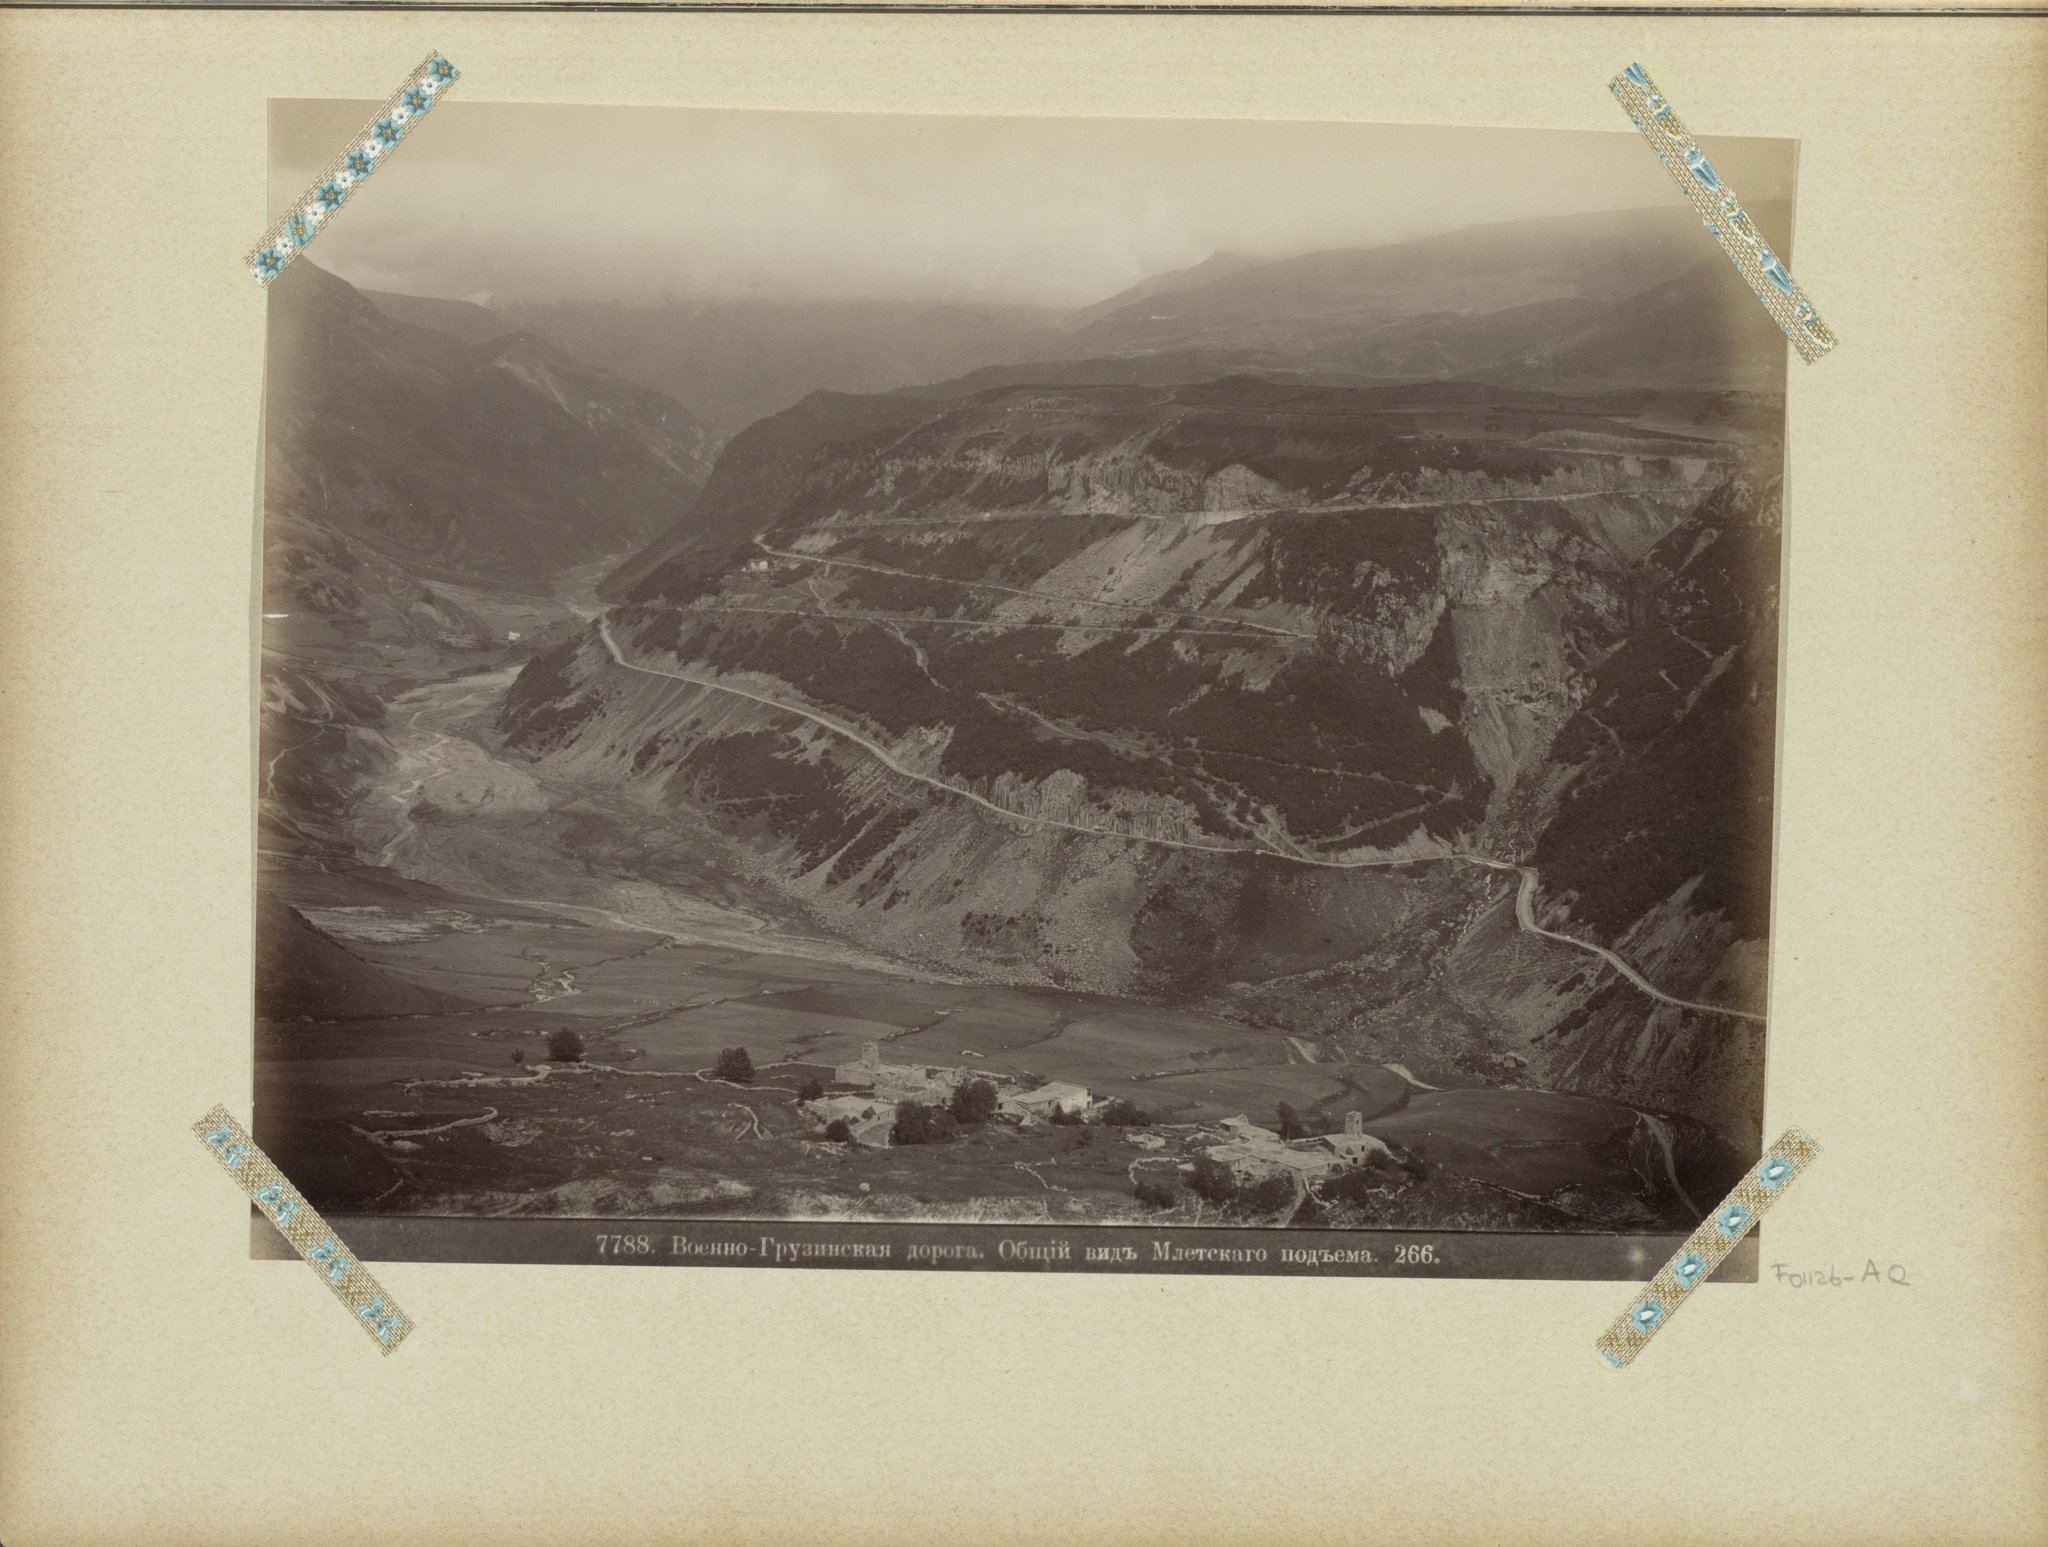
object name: photograph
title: Berglandschap met dorp aan de militaire weg in Georgië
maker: dimitri ivanovitch ermakov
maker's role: fotograaf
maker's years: 1845-1916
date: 1890-1900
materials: photographic support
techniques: albumen print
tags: prospect of village, silhouette of village, road, path, mountains (+ landscape with figures, staffage)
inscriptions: number: ‘7788’, number: ‘266’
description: Onderdeel van Fotoalbum met opnames van bezienswaardigheden in Georgië, Sint-Petersburg en Moskou.